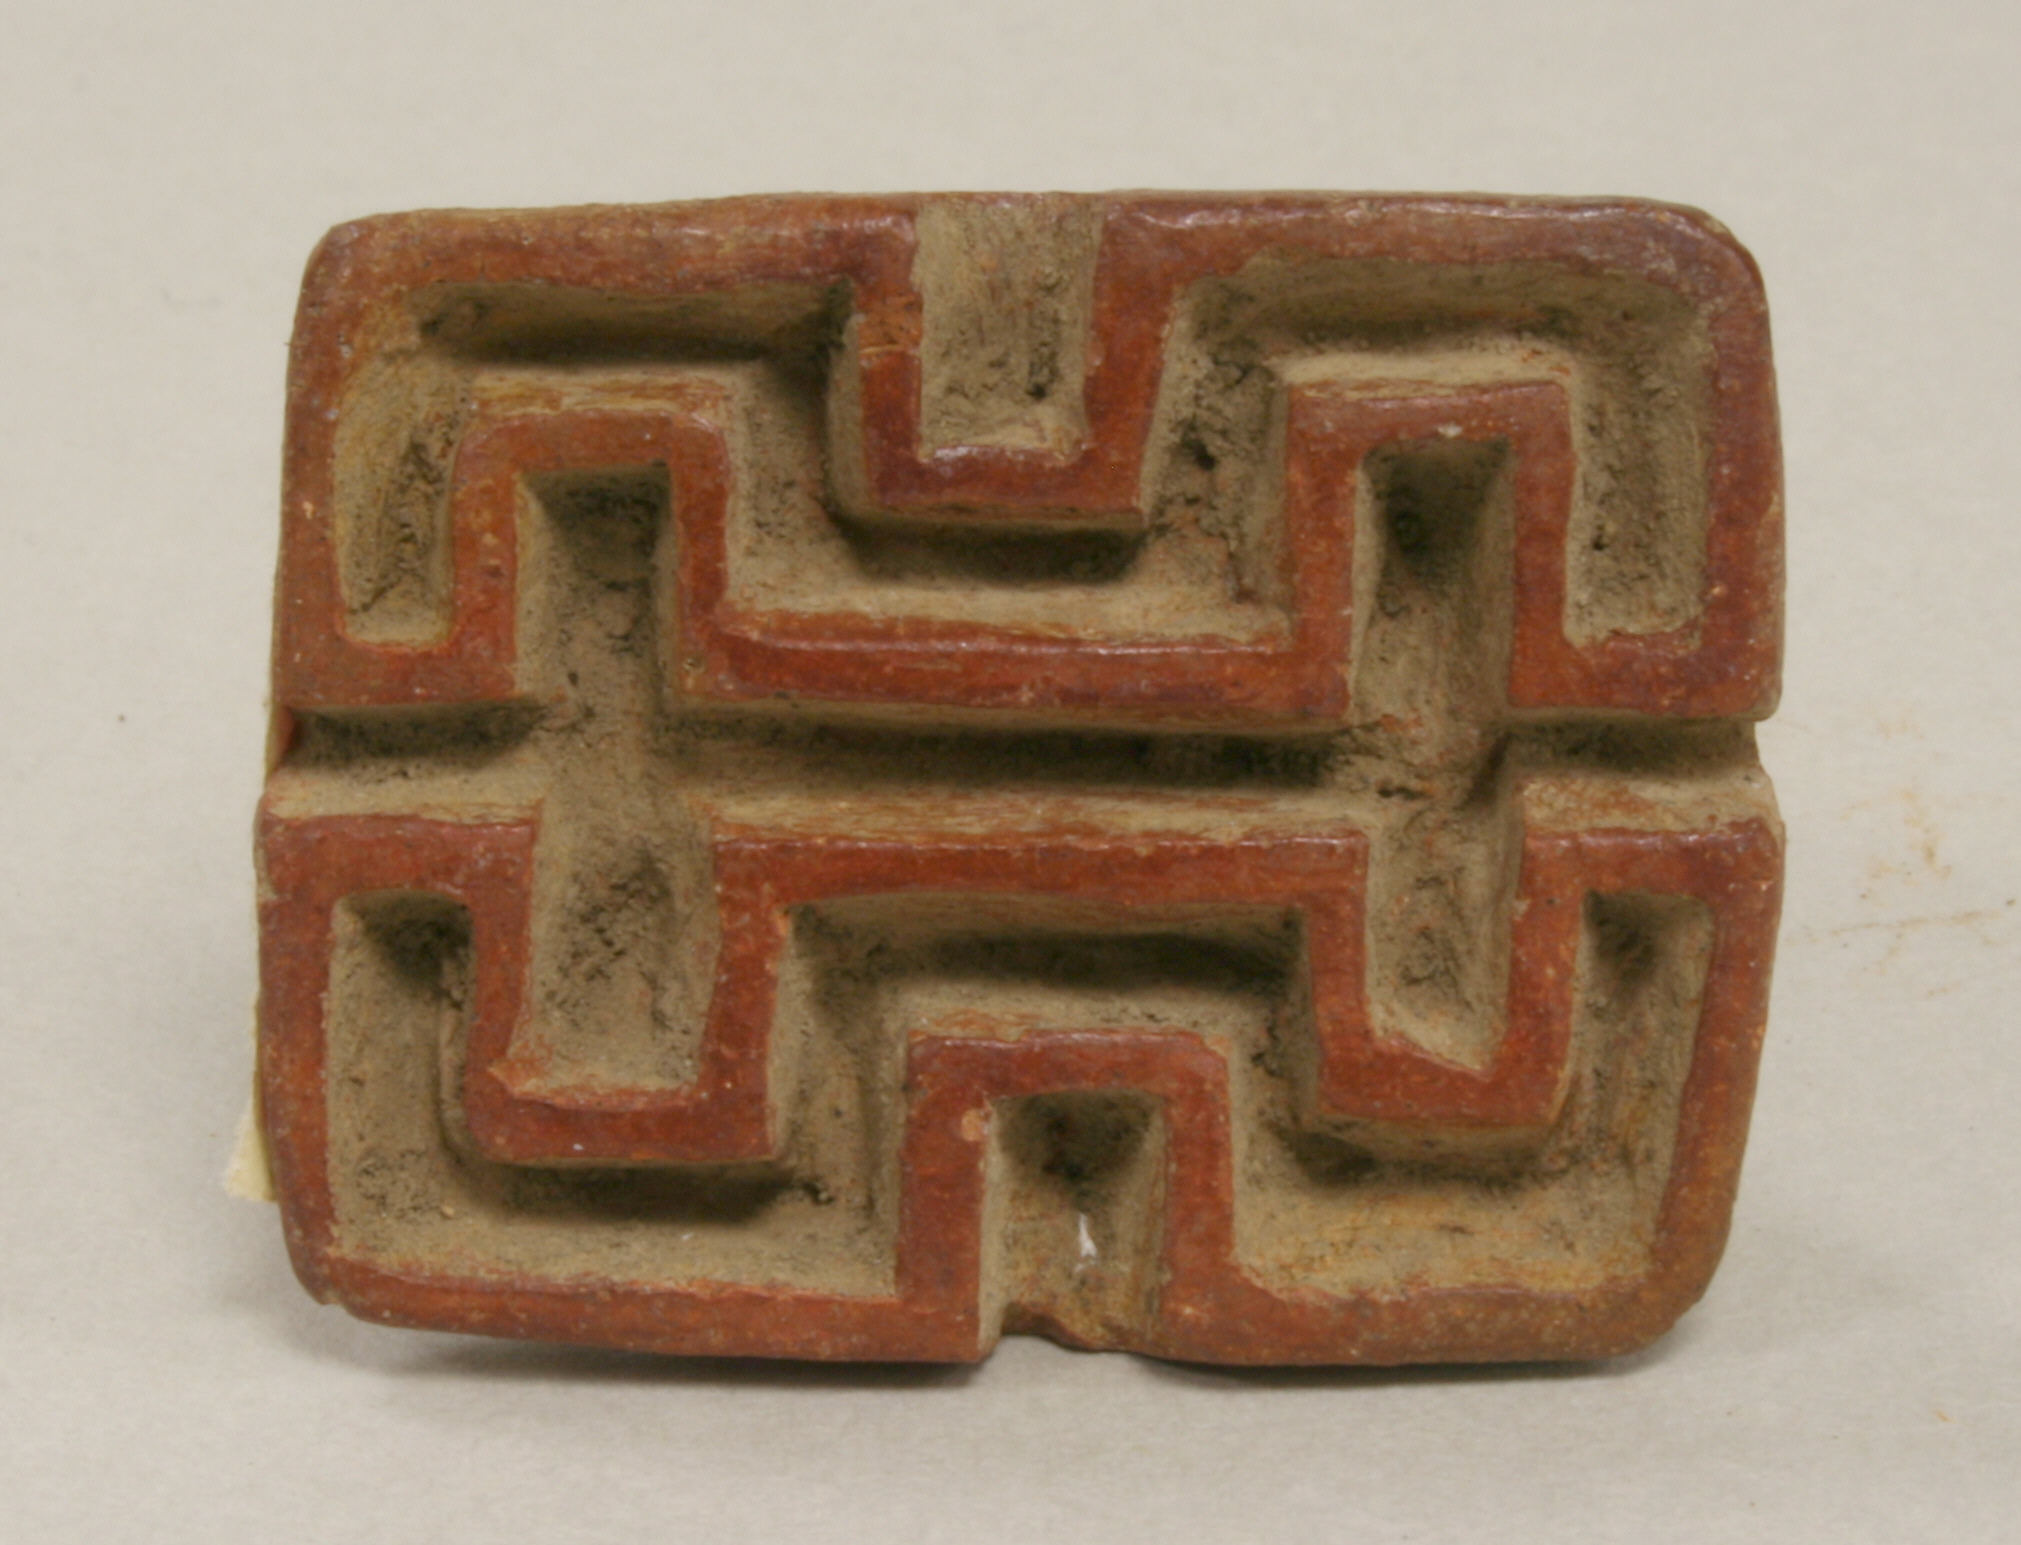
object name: stamp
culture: atlantic watershed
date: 401-600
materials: ceramic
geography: costa rica